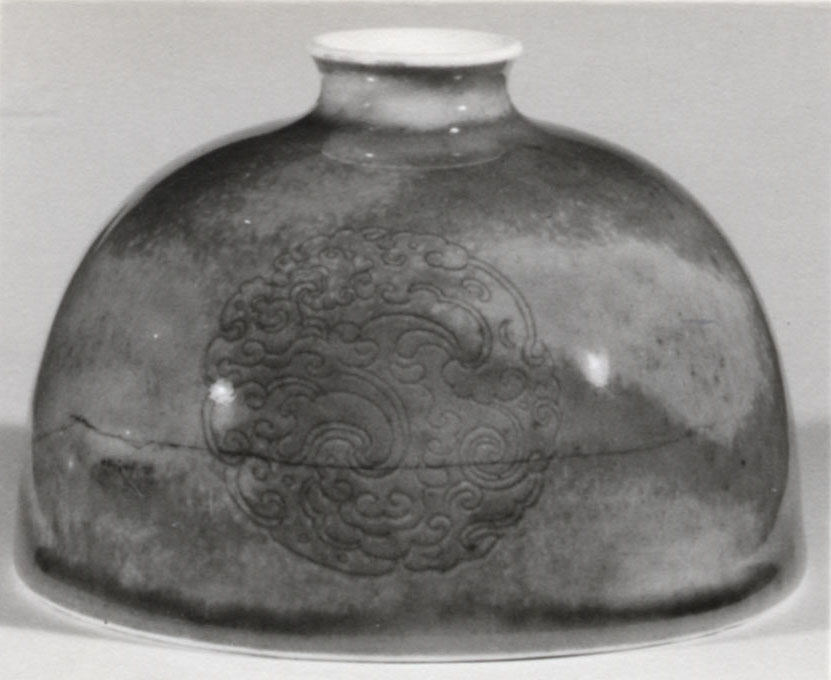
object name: jar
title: Water Jar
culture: chinese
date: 1678-1688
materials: glaze, porcelain